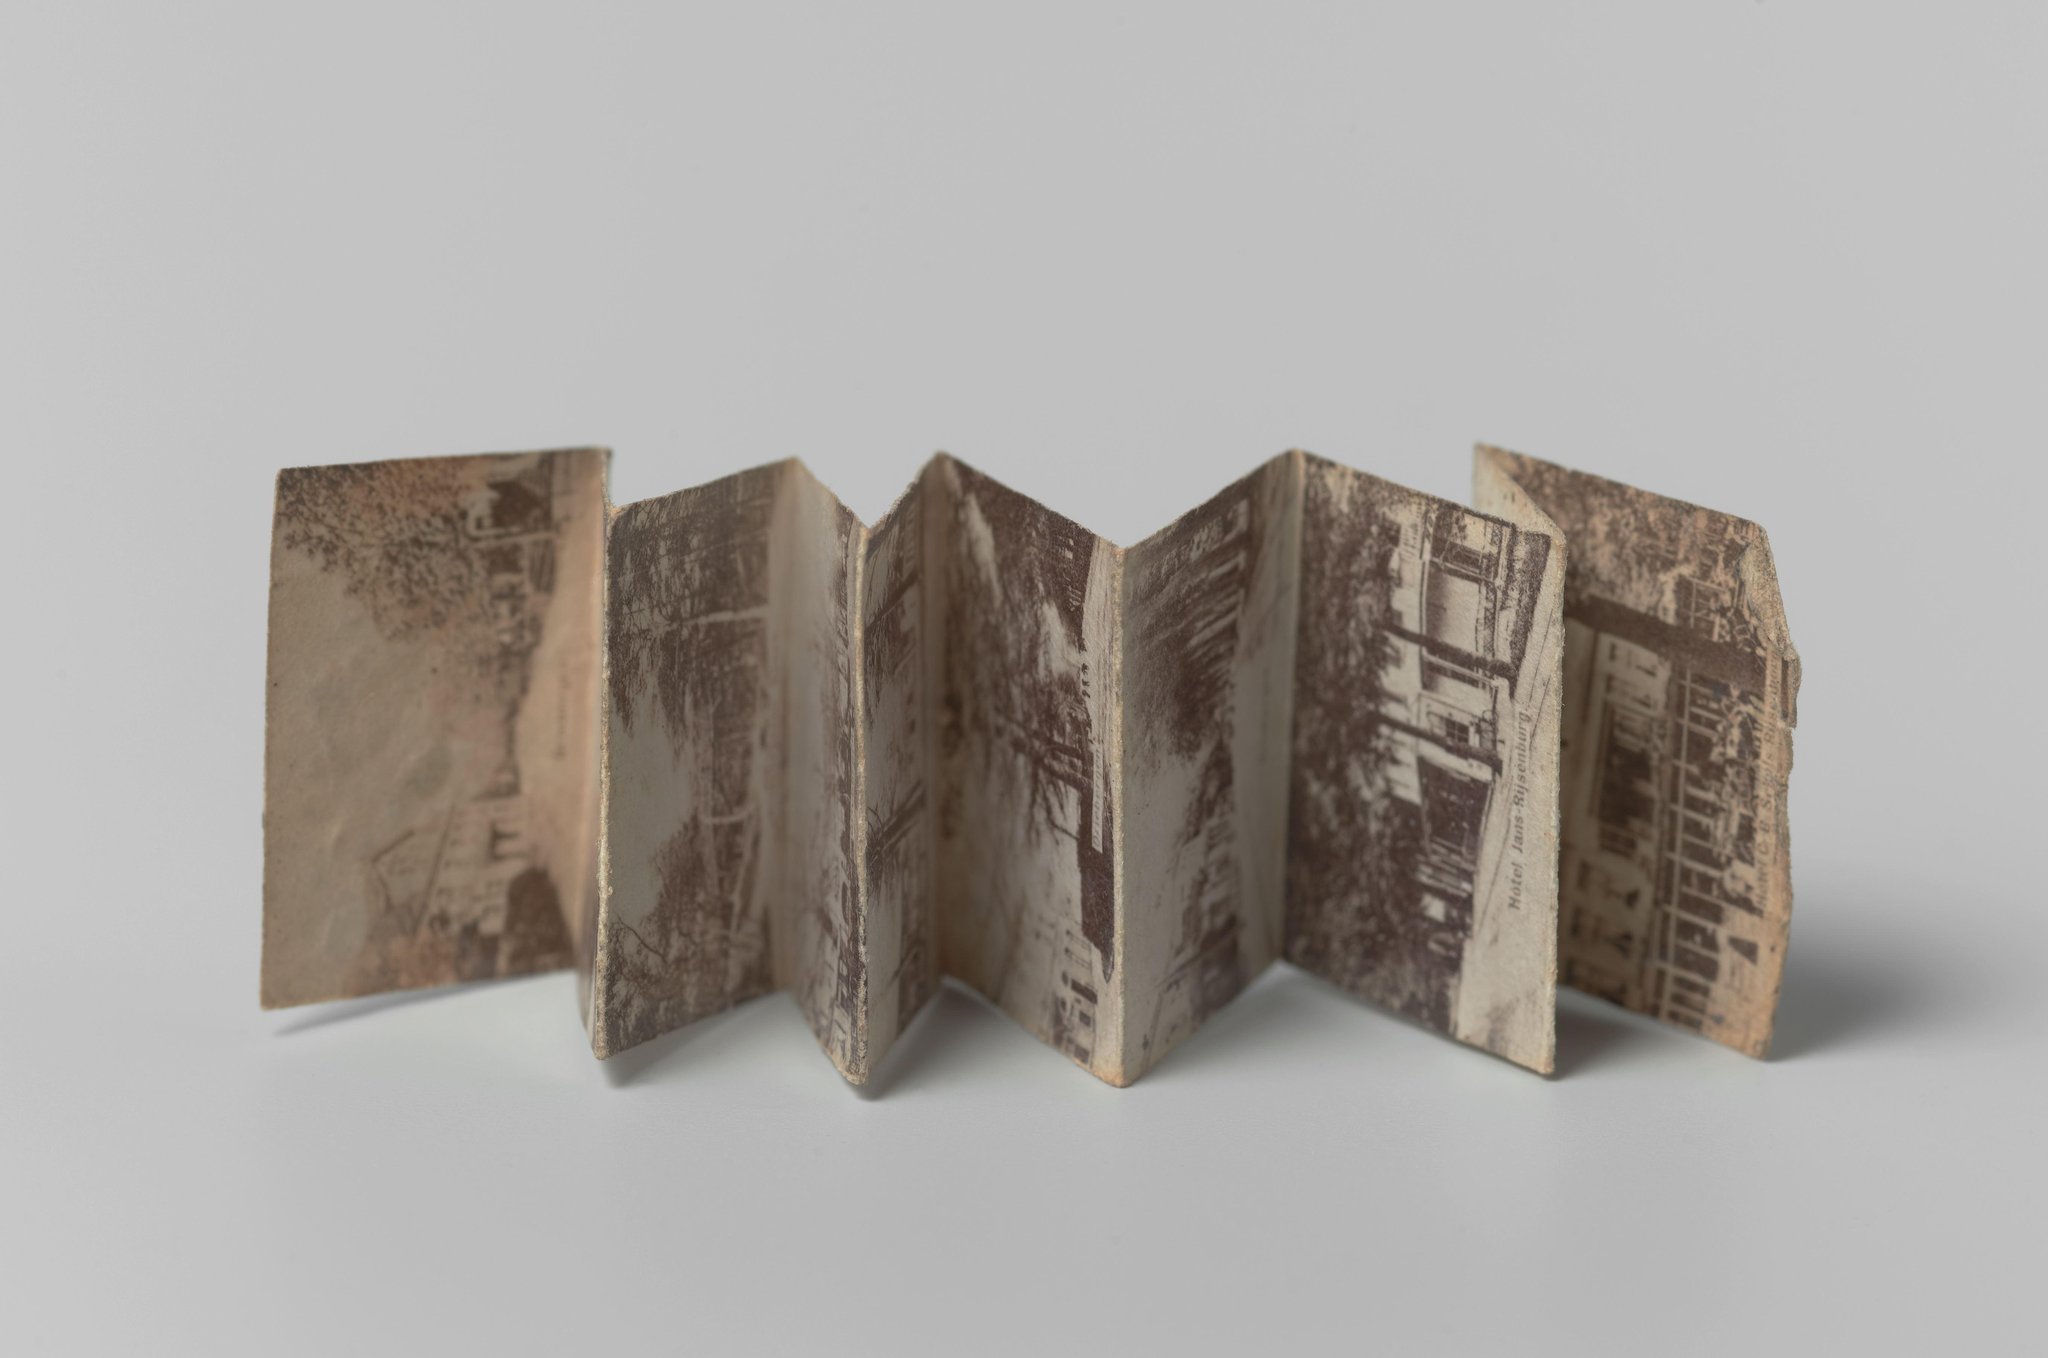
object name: photograph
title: Leporello van tien miniatuurfoto's met verschillende gezichten op Driebergen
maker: Anonymous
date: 1851-1900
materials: paper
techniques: albumen print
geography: driebergen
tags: city-view in general; 'veduta'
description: Leporello van tien miniatuurfoto's met verschillende gezichten op Driebergen, Utrecht.